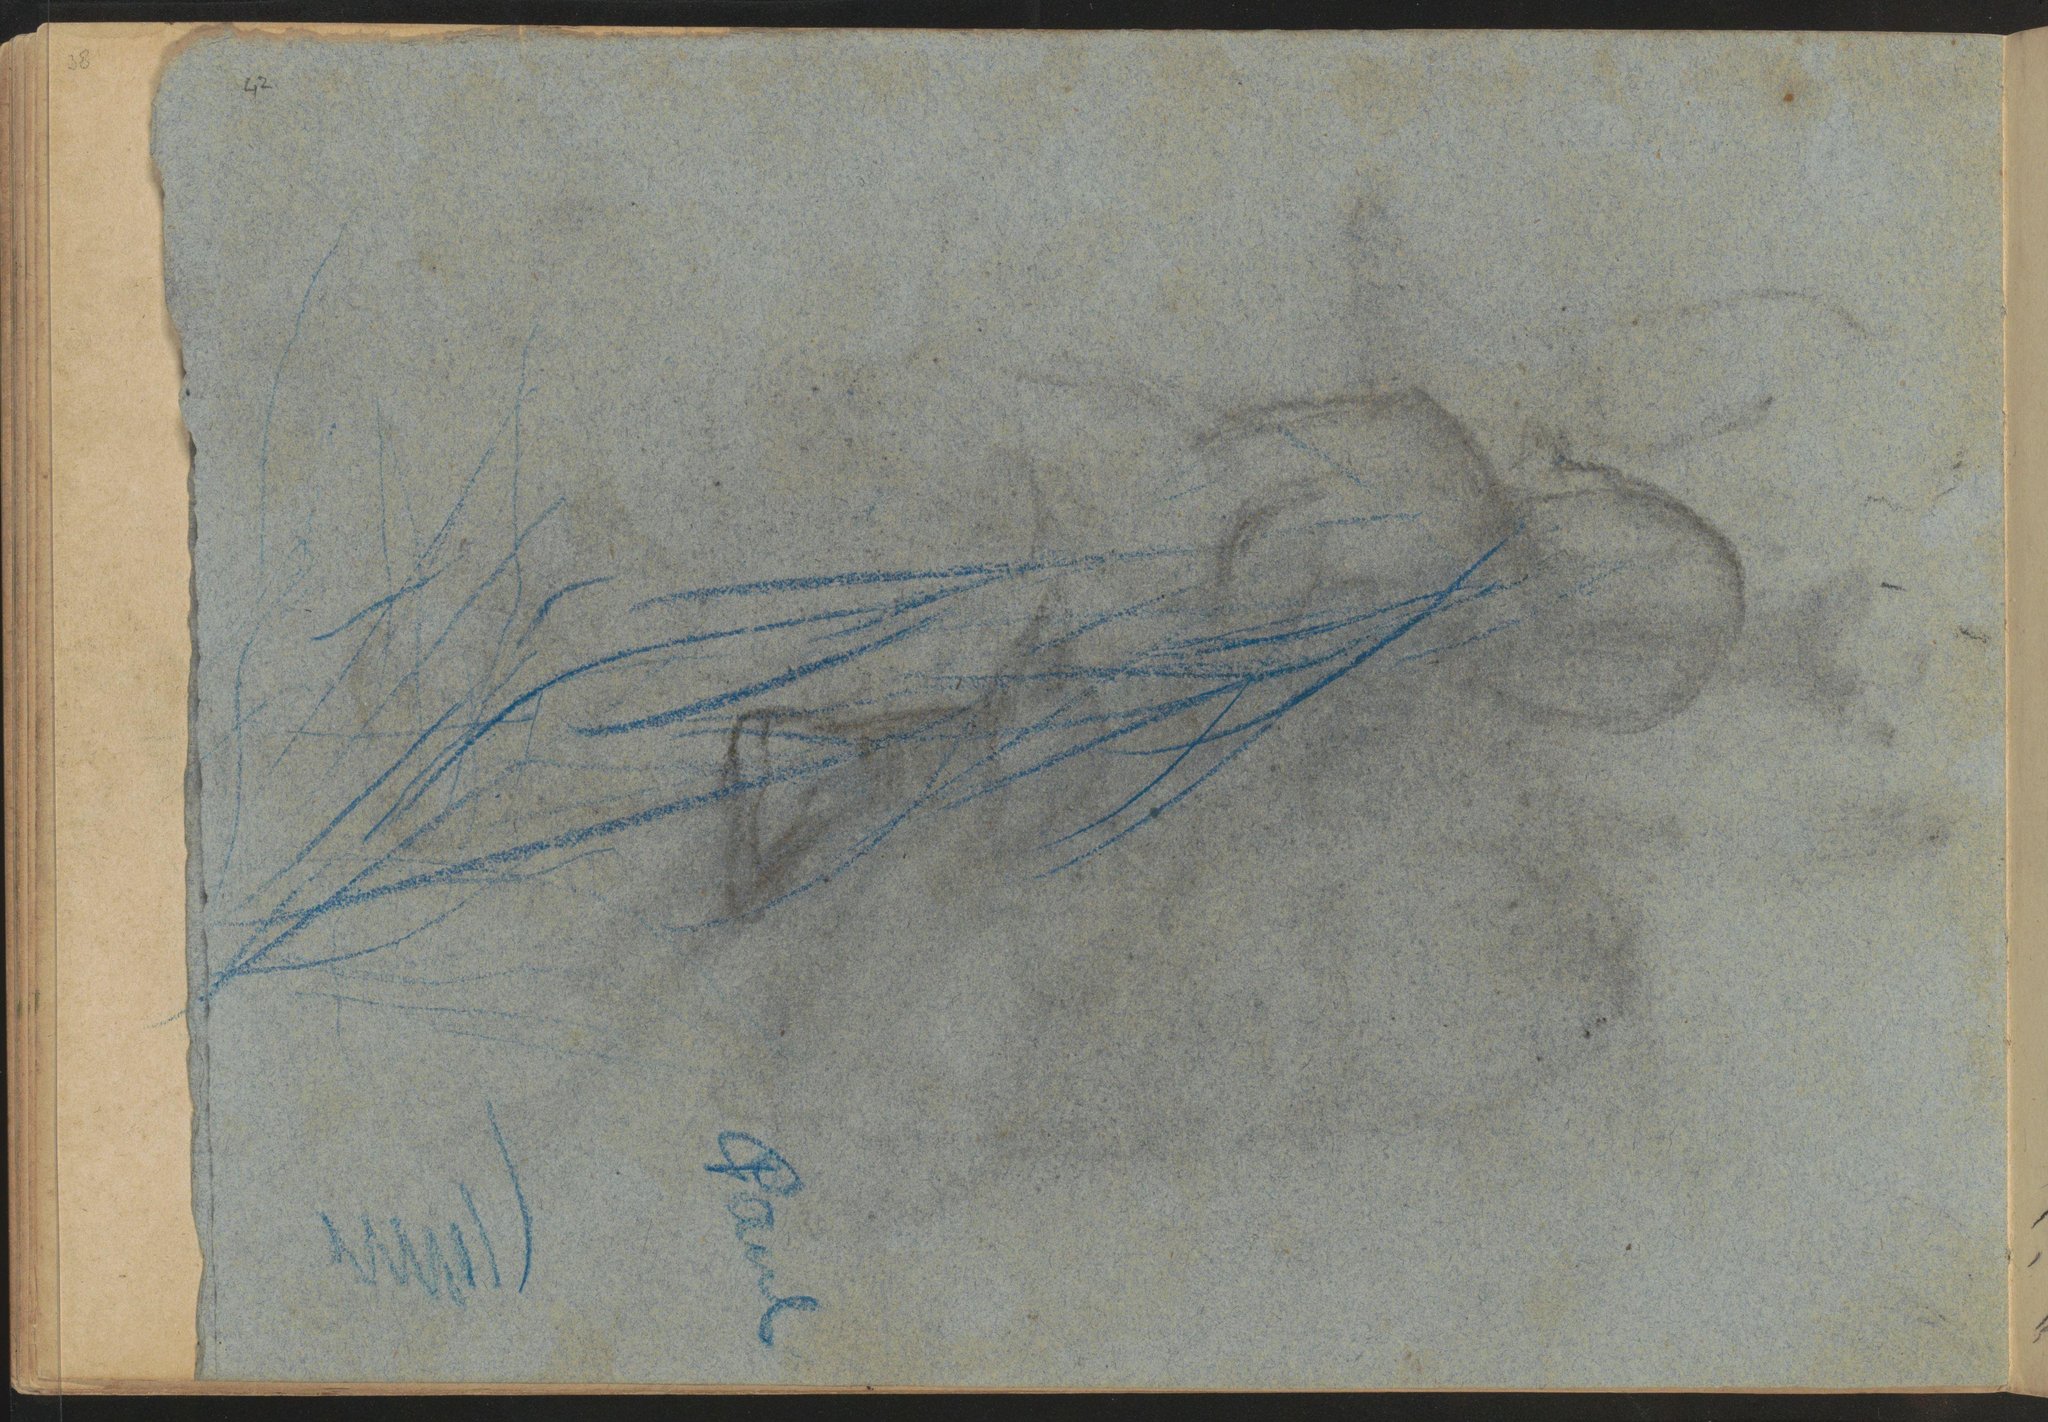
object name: sketchbook leaf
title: Zittend meisje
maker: willem witsen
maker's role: draughtsman, painter, print maker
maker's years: 1860-1923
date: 1884-1887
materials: chalk, paper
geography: ewijkshoeve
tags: girl (child between toddler and youth) (+ sitting)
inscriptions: annotation: ‘Paul’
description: Pagina 42 uit een schetsboek met 29 bladen.